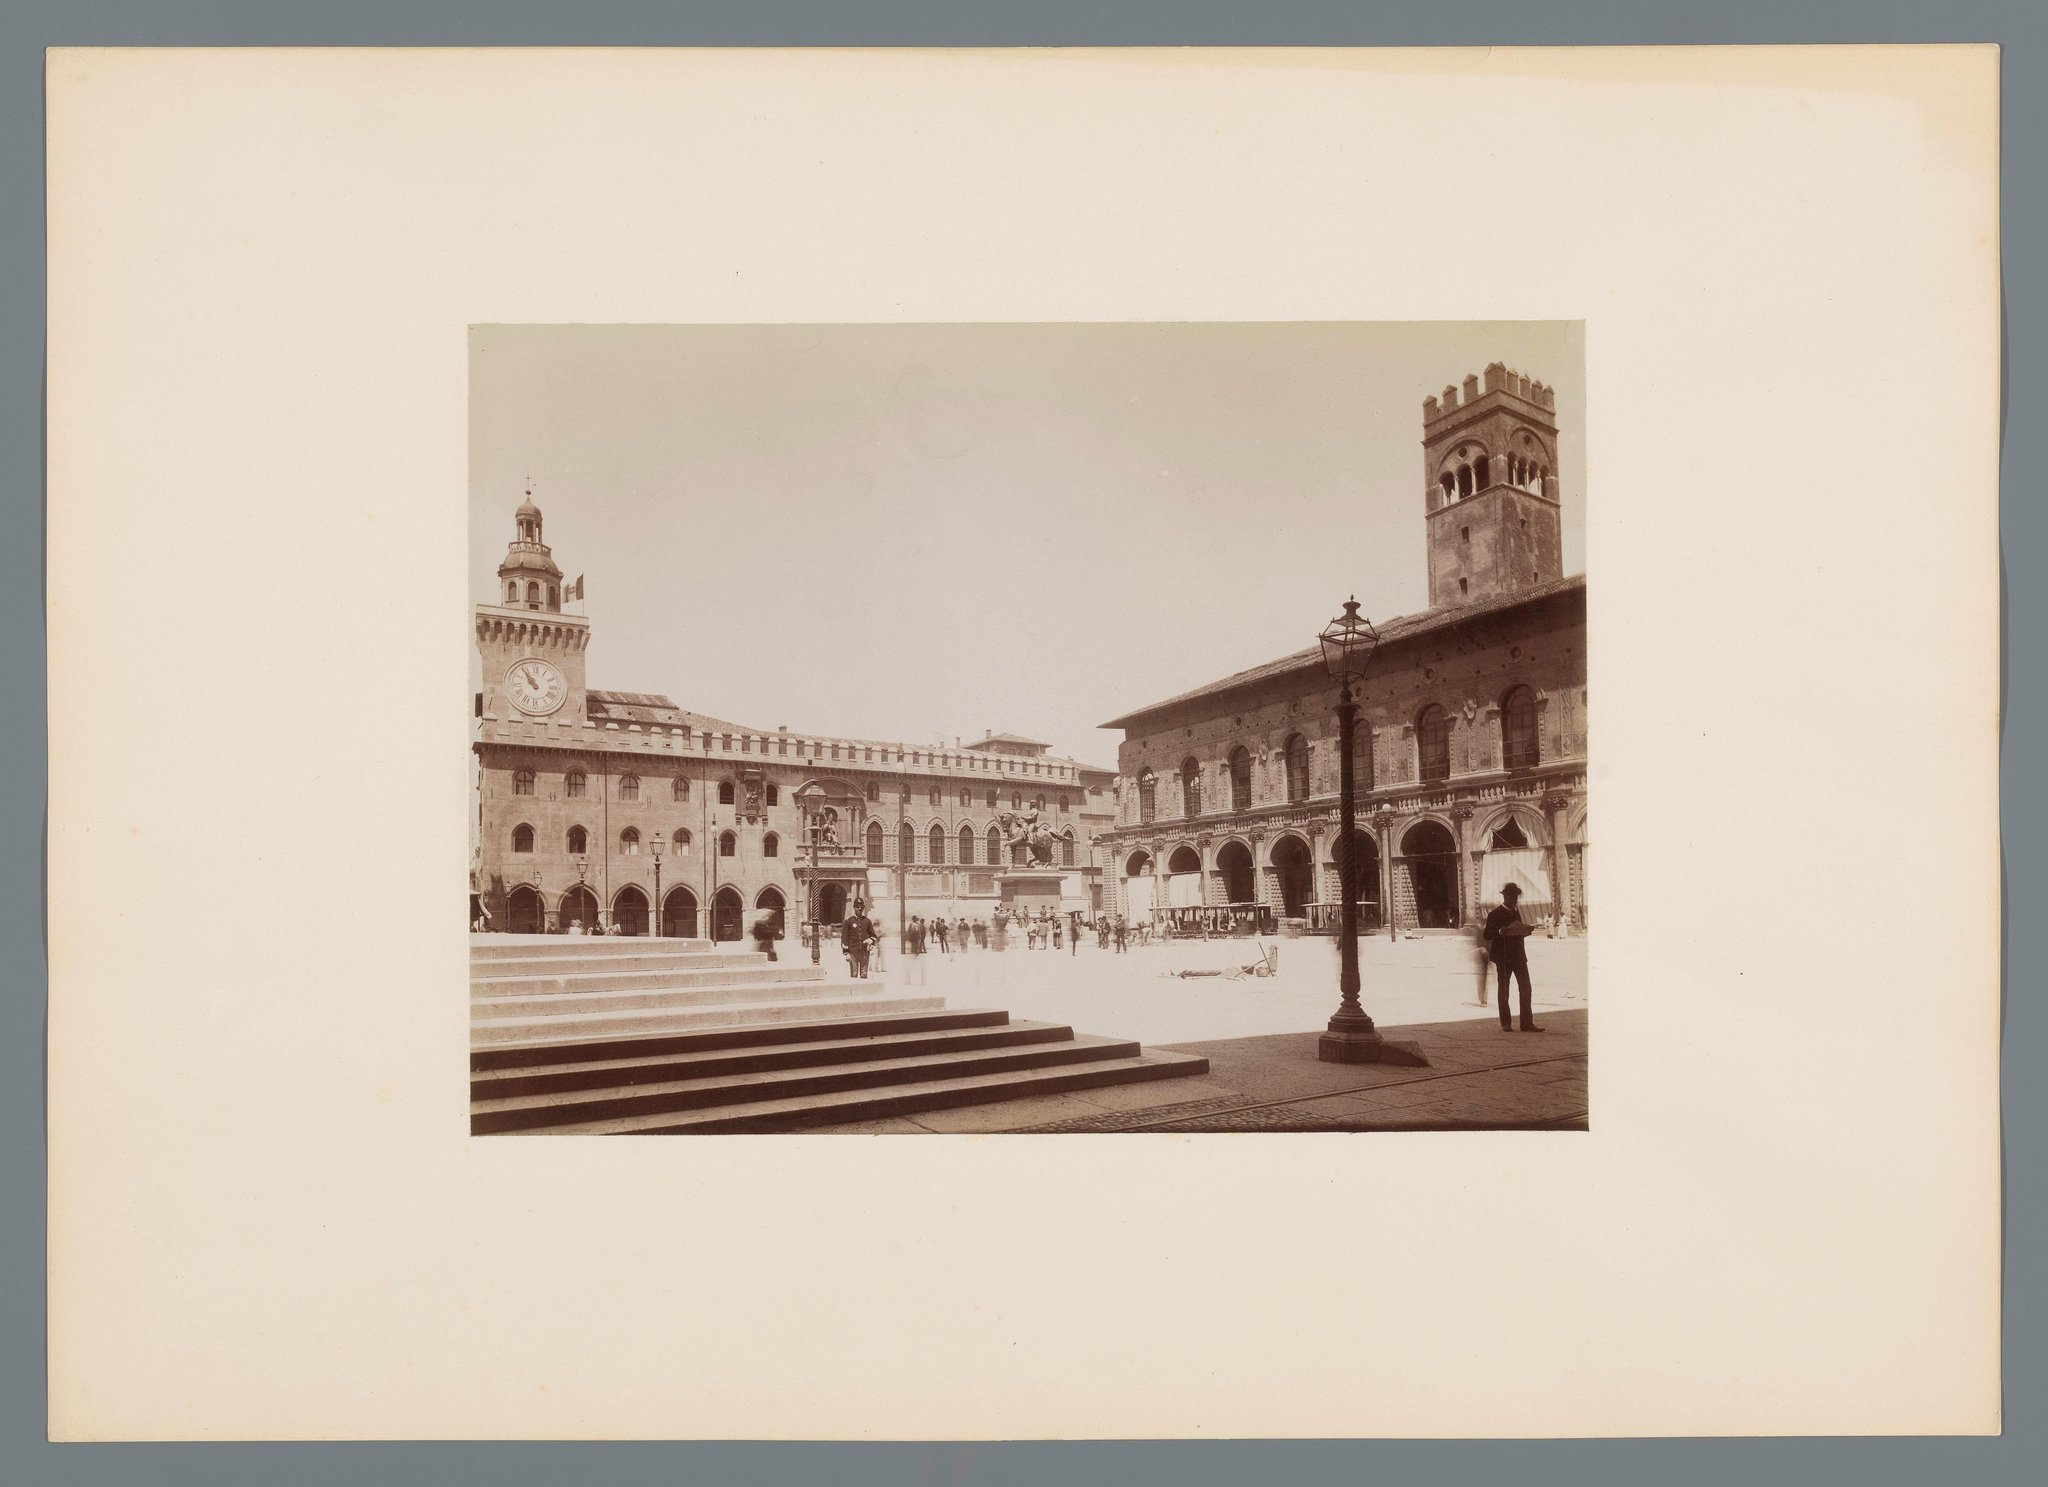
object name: stereograph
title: Gezicht op de Pont Notre-Dame in Parijs met paardenkarren met goederen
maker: Anonymous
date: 1850-1880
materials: cardboard, photographic support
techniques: albumen print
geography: paris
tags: four-wheeled, animal-drawn vehicle, e.g.: cab, carriage, coach, bridge in city across river, canal, etc.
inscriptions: inscription: ‘Pont Notre Dame, Paris Parijs (Frankrijk) [...]’